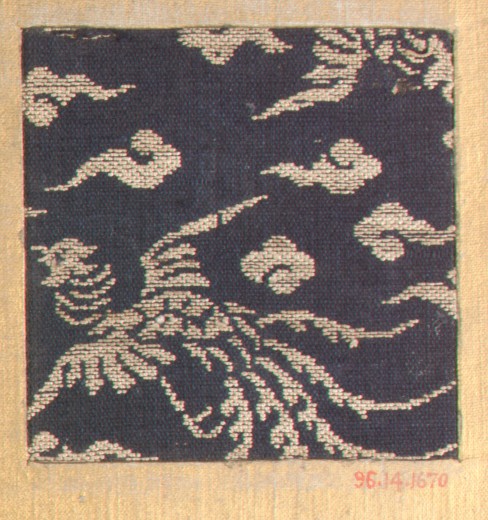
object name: piece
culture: japanese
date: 1701-1900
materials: silk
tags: birds